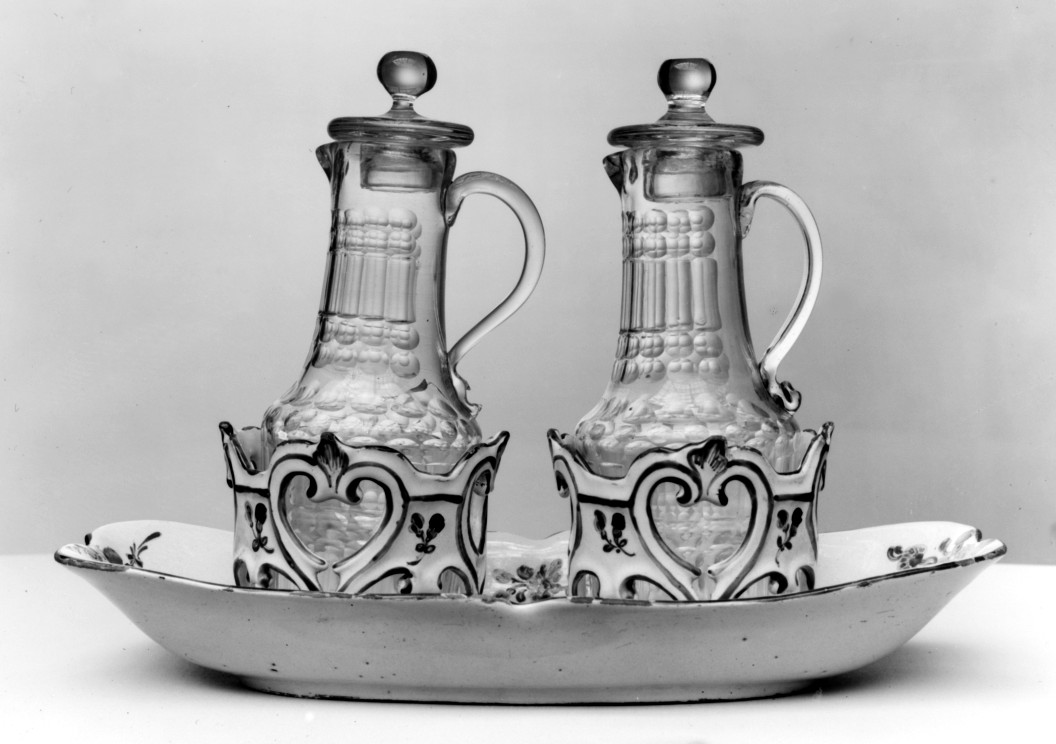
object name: cruet stand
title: Cruet-stand with cruets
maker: levavasseur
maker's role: manufactory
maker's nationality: french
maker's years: 1715-1825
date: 1788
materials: faience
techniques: glazing